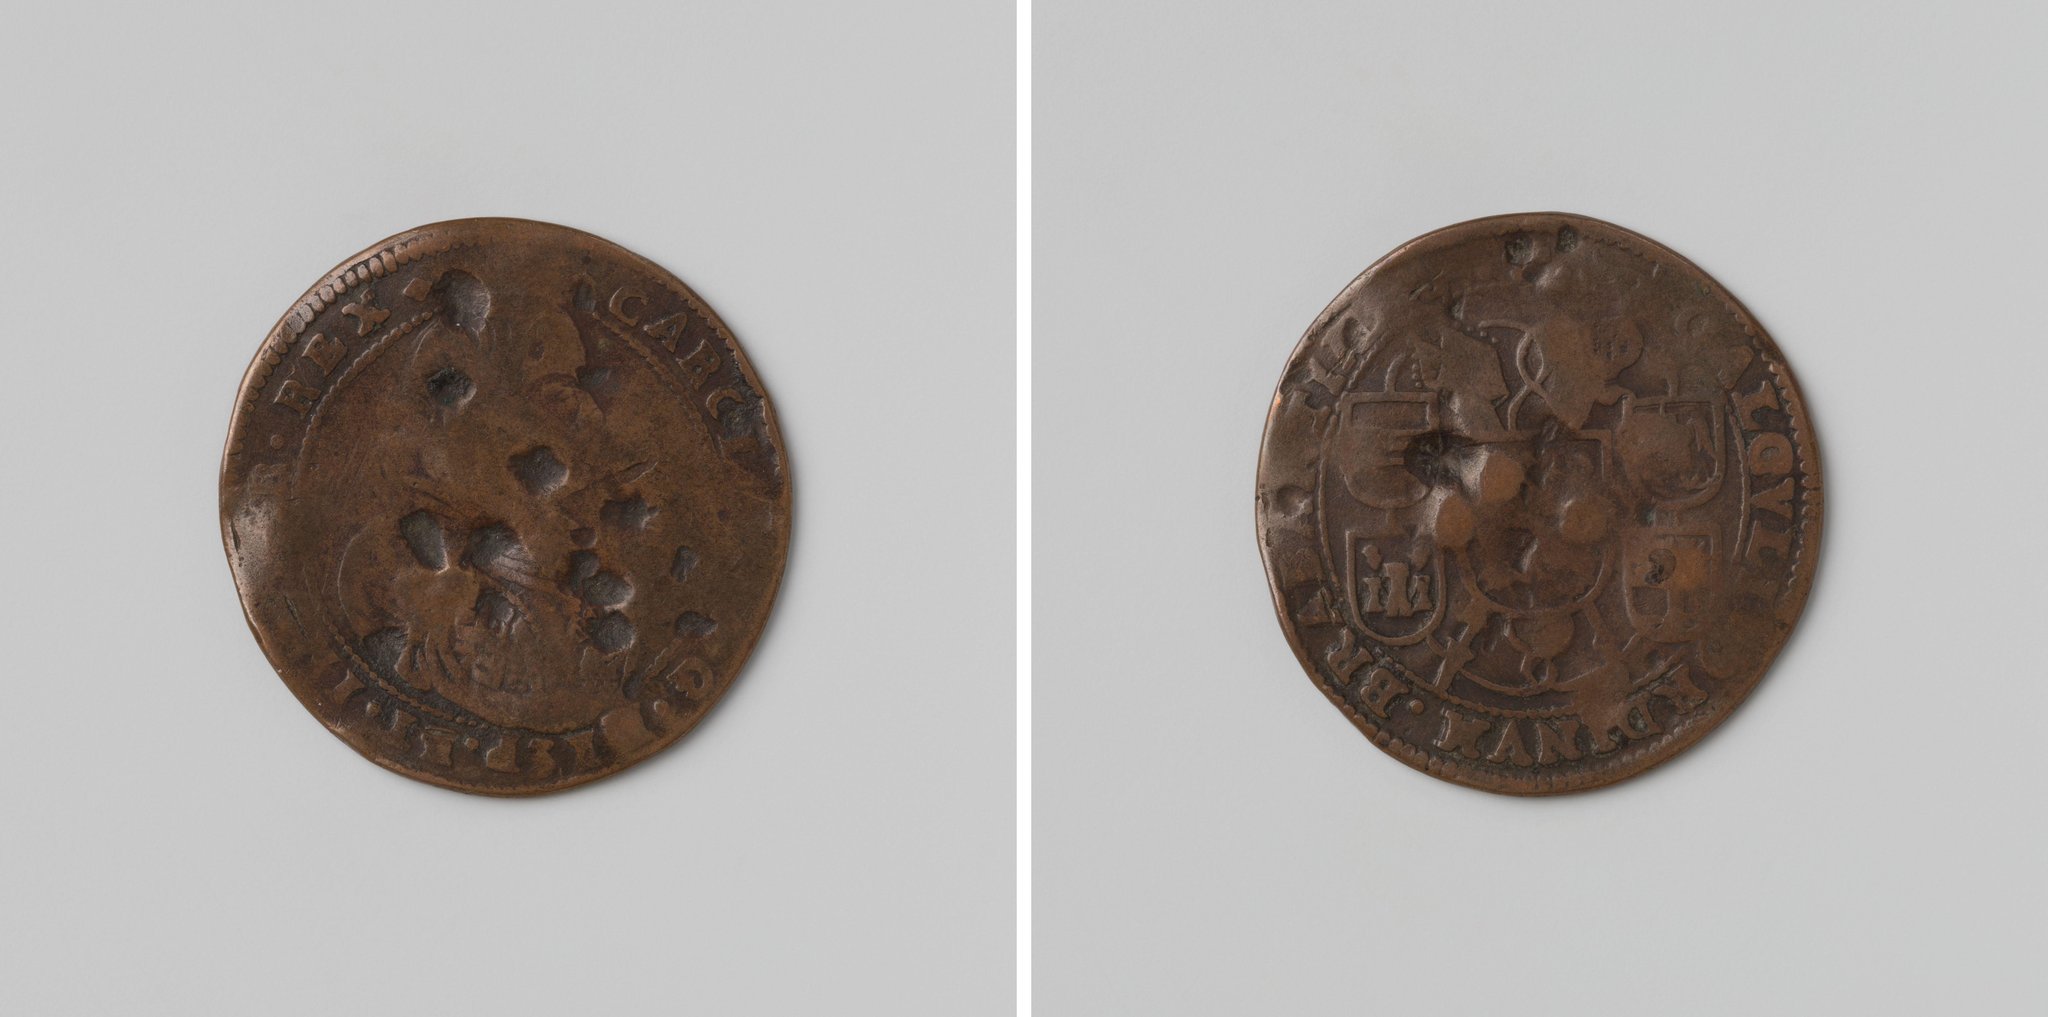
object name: jeton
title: Karel II, koning van Spanje, rekenpenning geslagen op last van de Staten van Brabant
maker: Anonymous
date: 1669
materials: copper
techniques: striking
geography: belgium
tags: karel ii (koning van spanje), brabant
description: Koperen penning. Voorzijde: borststuk man binnen omschrift. Keerzijde: wapenschild op een gekruiste bisschopsstaf, bekroond met een mijter, en een lans, bekroond met een helm, omgeven door vier met koord samengebonden wapenschilden binnen omschrift